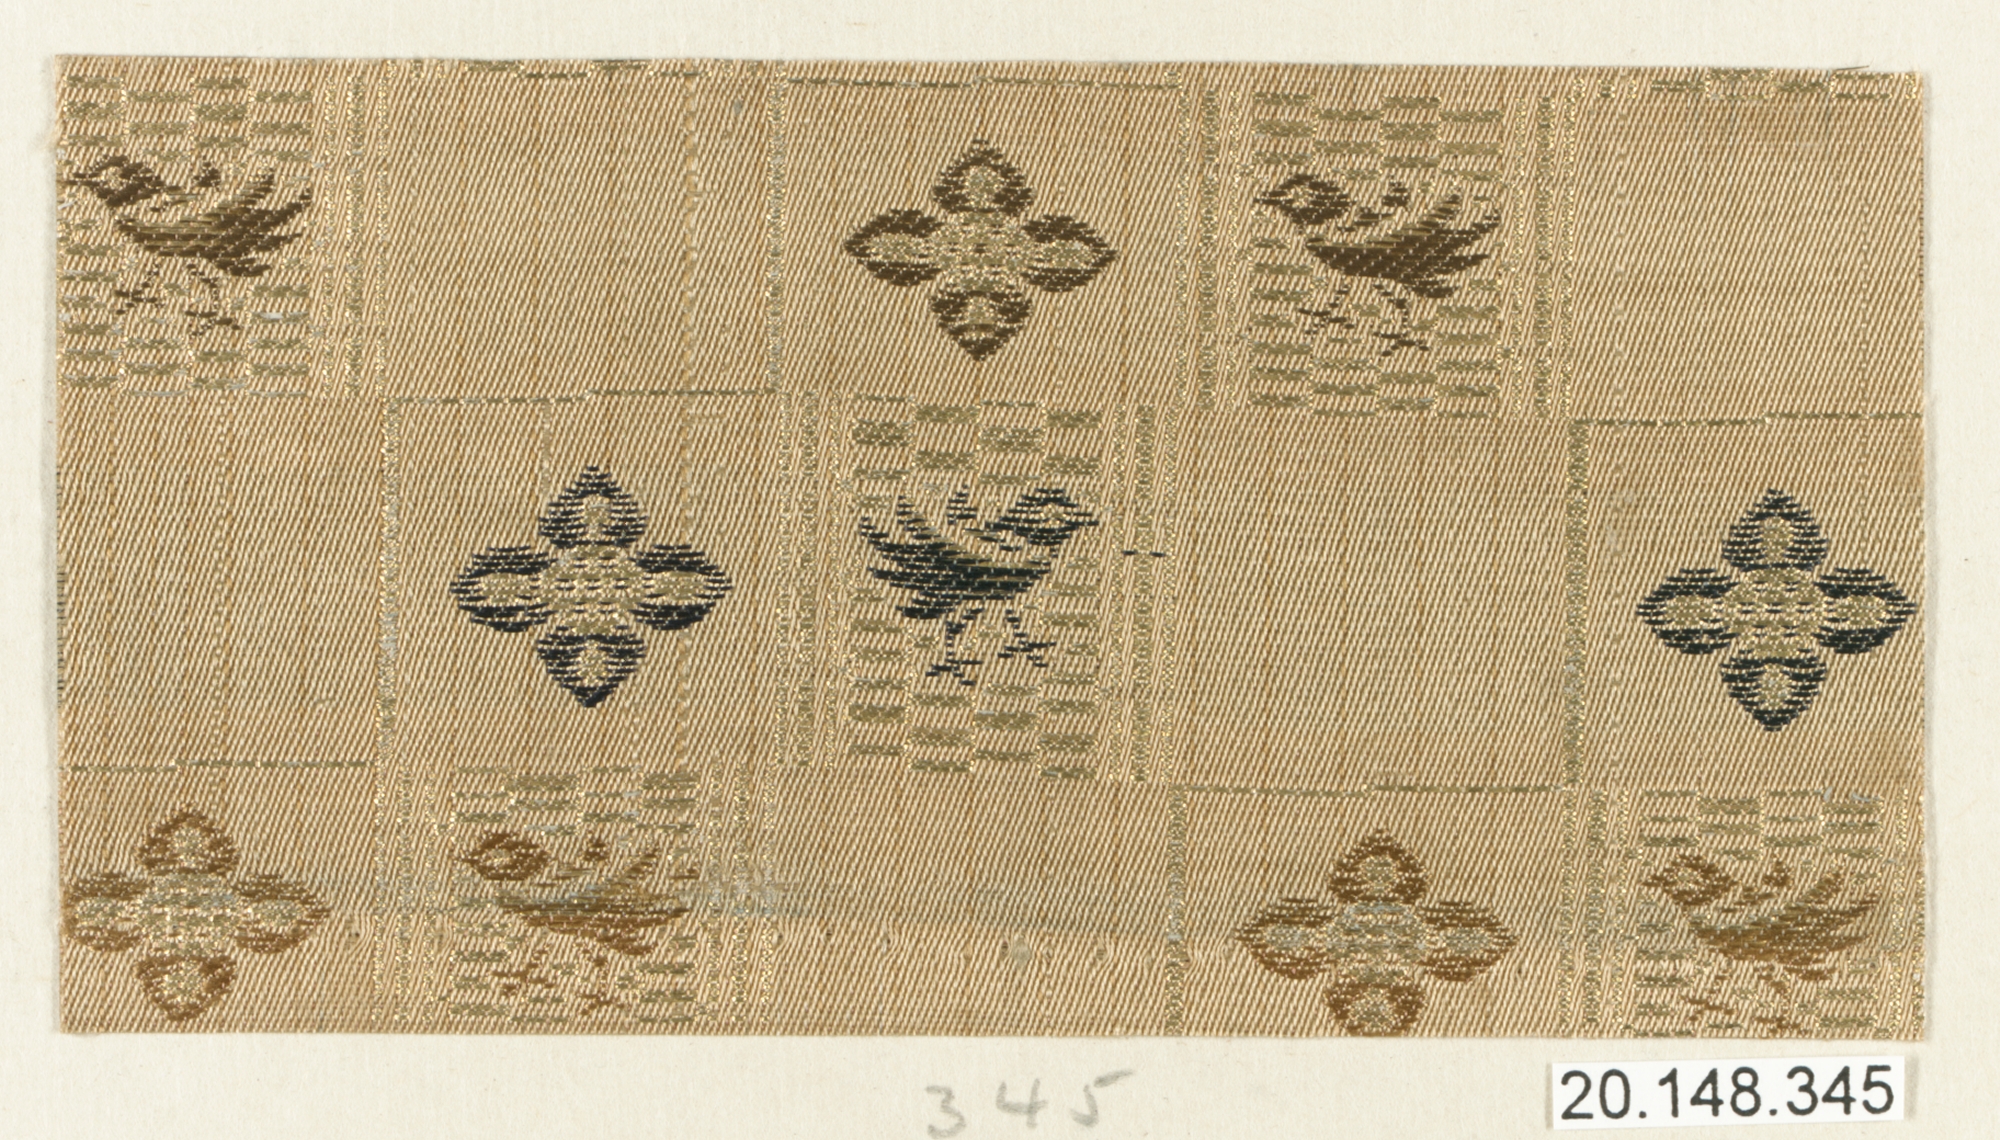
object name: piece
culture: japanese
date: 1701-1800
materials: silk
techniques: compound weave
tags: birds,flowers